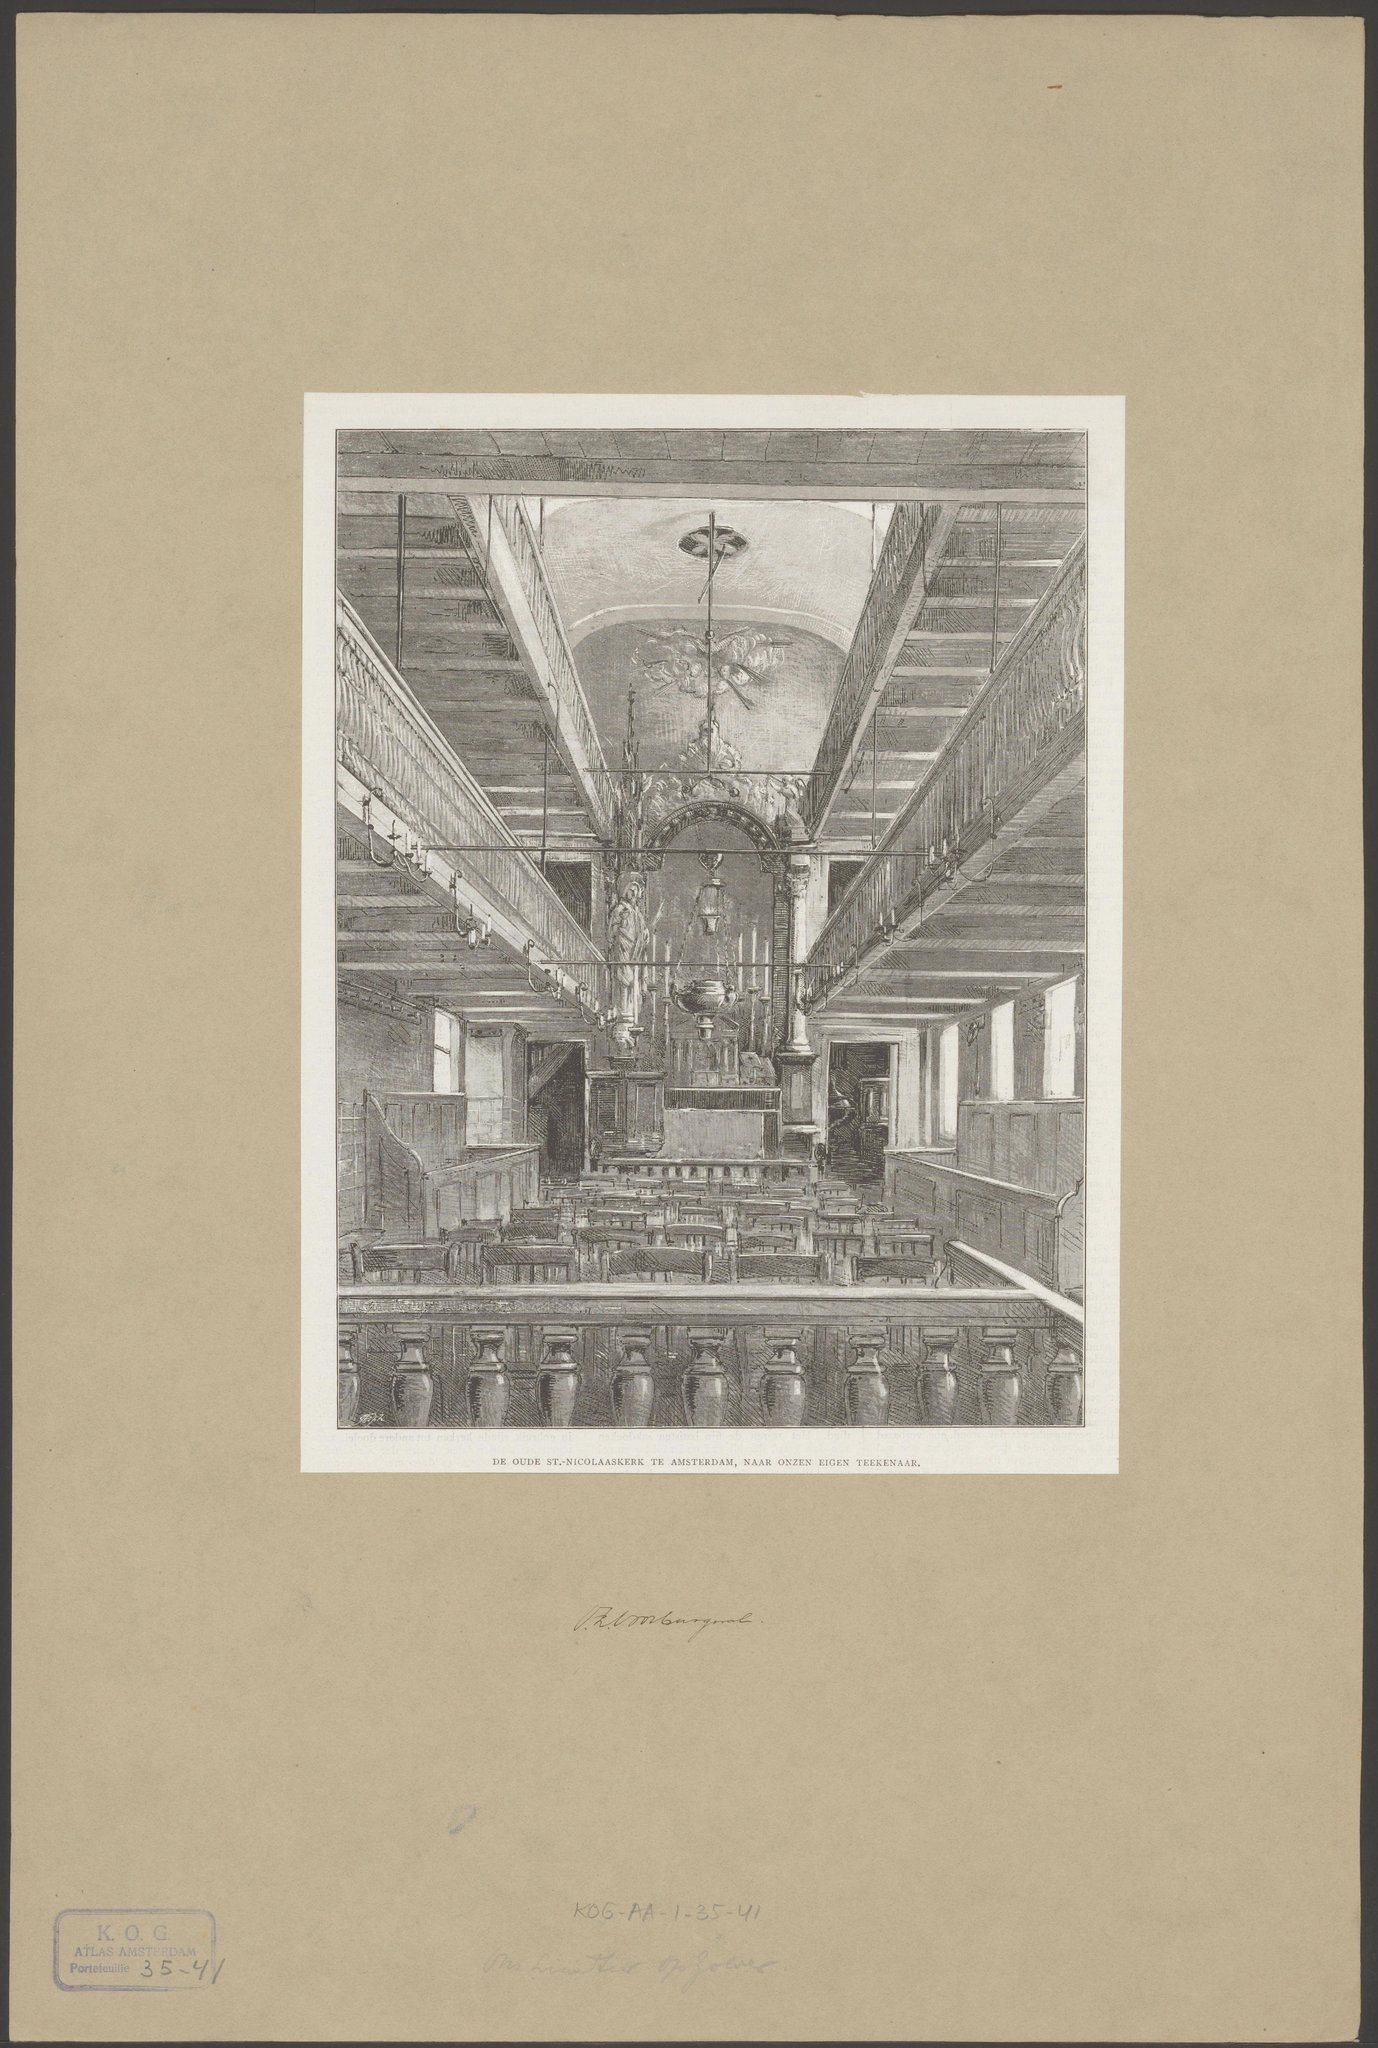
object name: photomechanical print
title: Gezicht op het interieur van Ons' Lieve Heer op Solder te Amsterdam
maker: Anonymous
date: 1900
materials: paper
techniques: letterpress printing, line block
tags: interior of church, st. nicholas consecrated bishop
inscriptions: collector's mark: ‘35-41’ Lugt 1641b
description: Onderwerpsrubriek binnen de Atlas Amsterdam: Kerkwezen: Hervormde Gemeente: Oude Kerk van buiten.